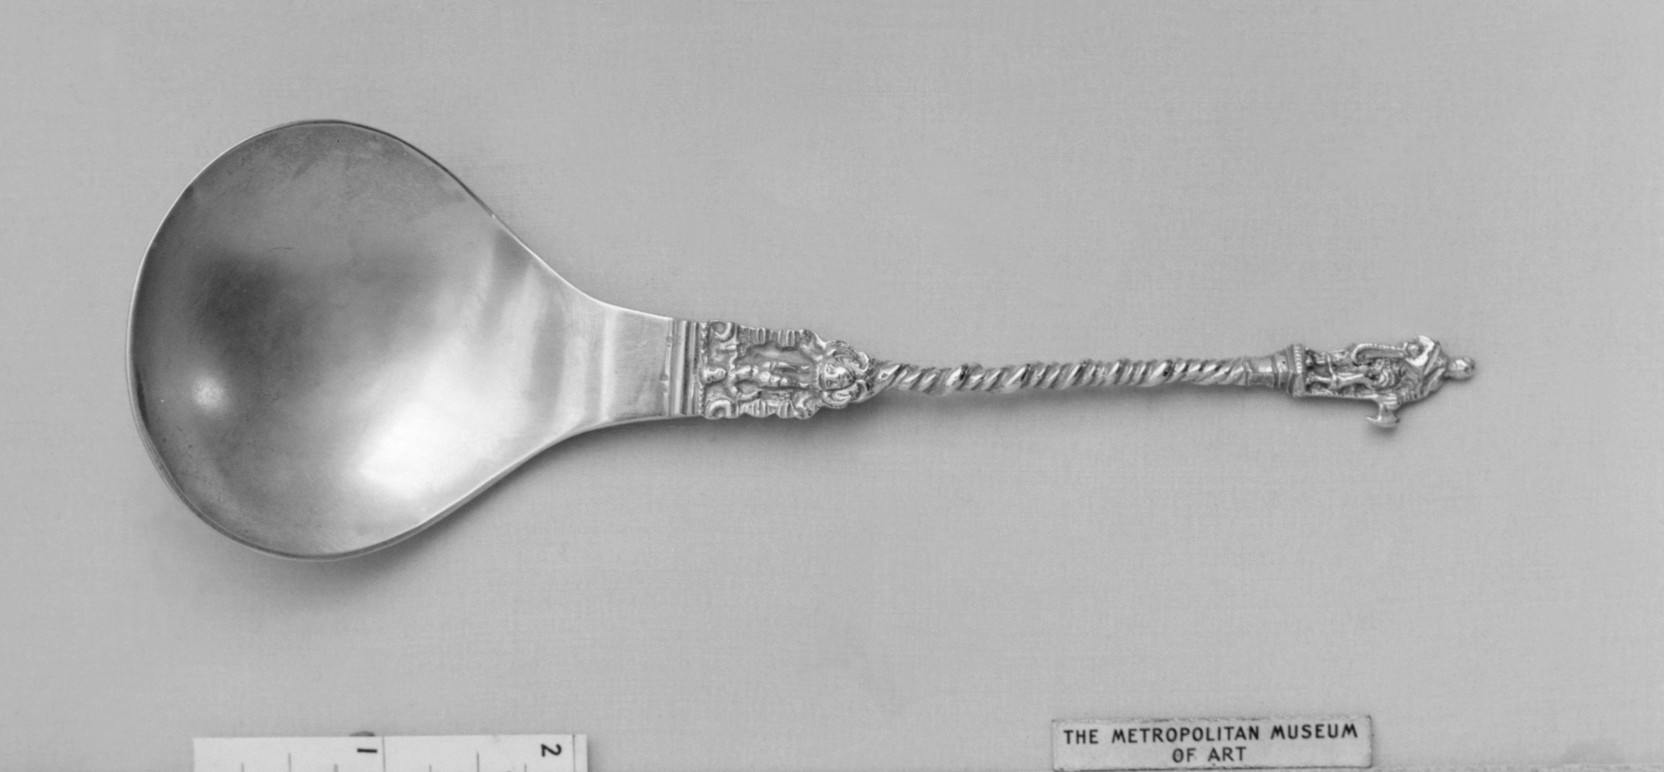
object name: apostle spoon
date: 1851-1900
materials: silver